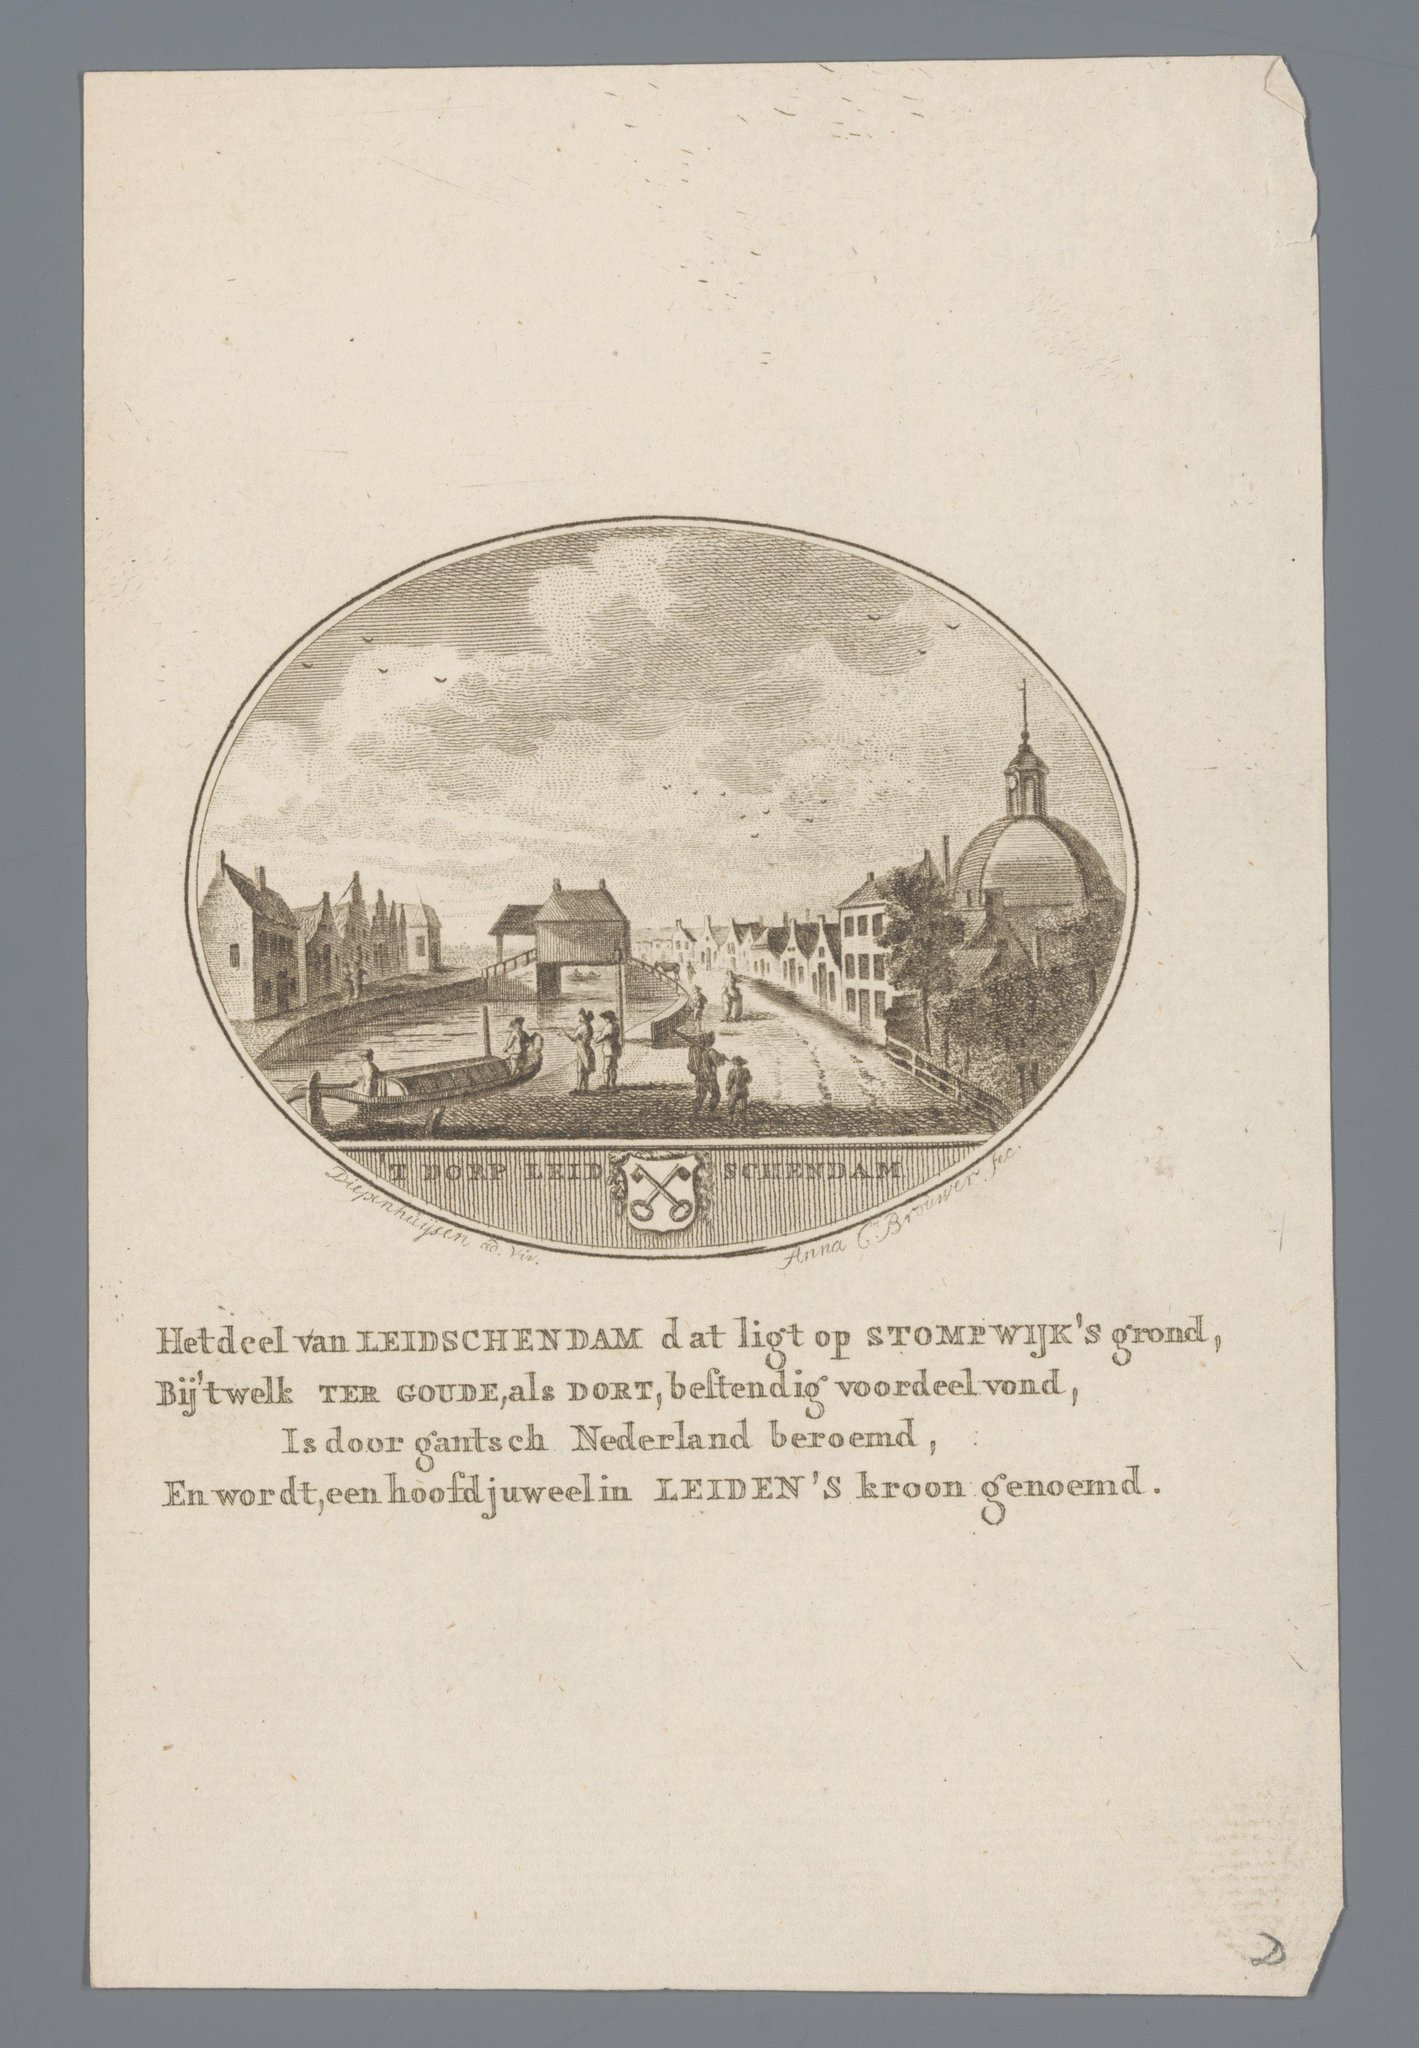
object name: book illustration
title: Gezicht op Leidschendam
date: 1799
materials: paper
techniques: etching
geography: netherlands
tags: village, canals, waters (in village) (+ city(-scape) with figures, staffage)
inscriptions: collector's mark: Lugt 2228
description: Prent uit: Ollefen, Lieve van. De Nederlandsche stad- en dorp-beschrijver. Amsterdam: Hendrik Arend Banse, 1799, dl. 7.